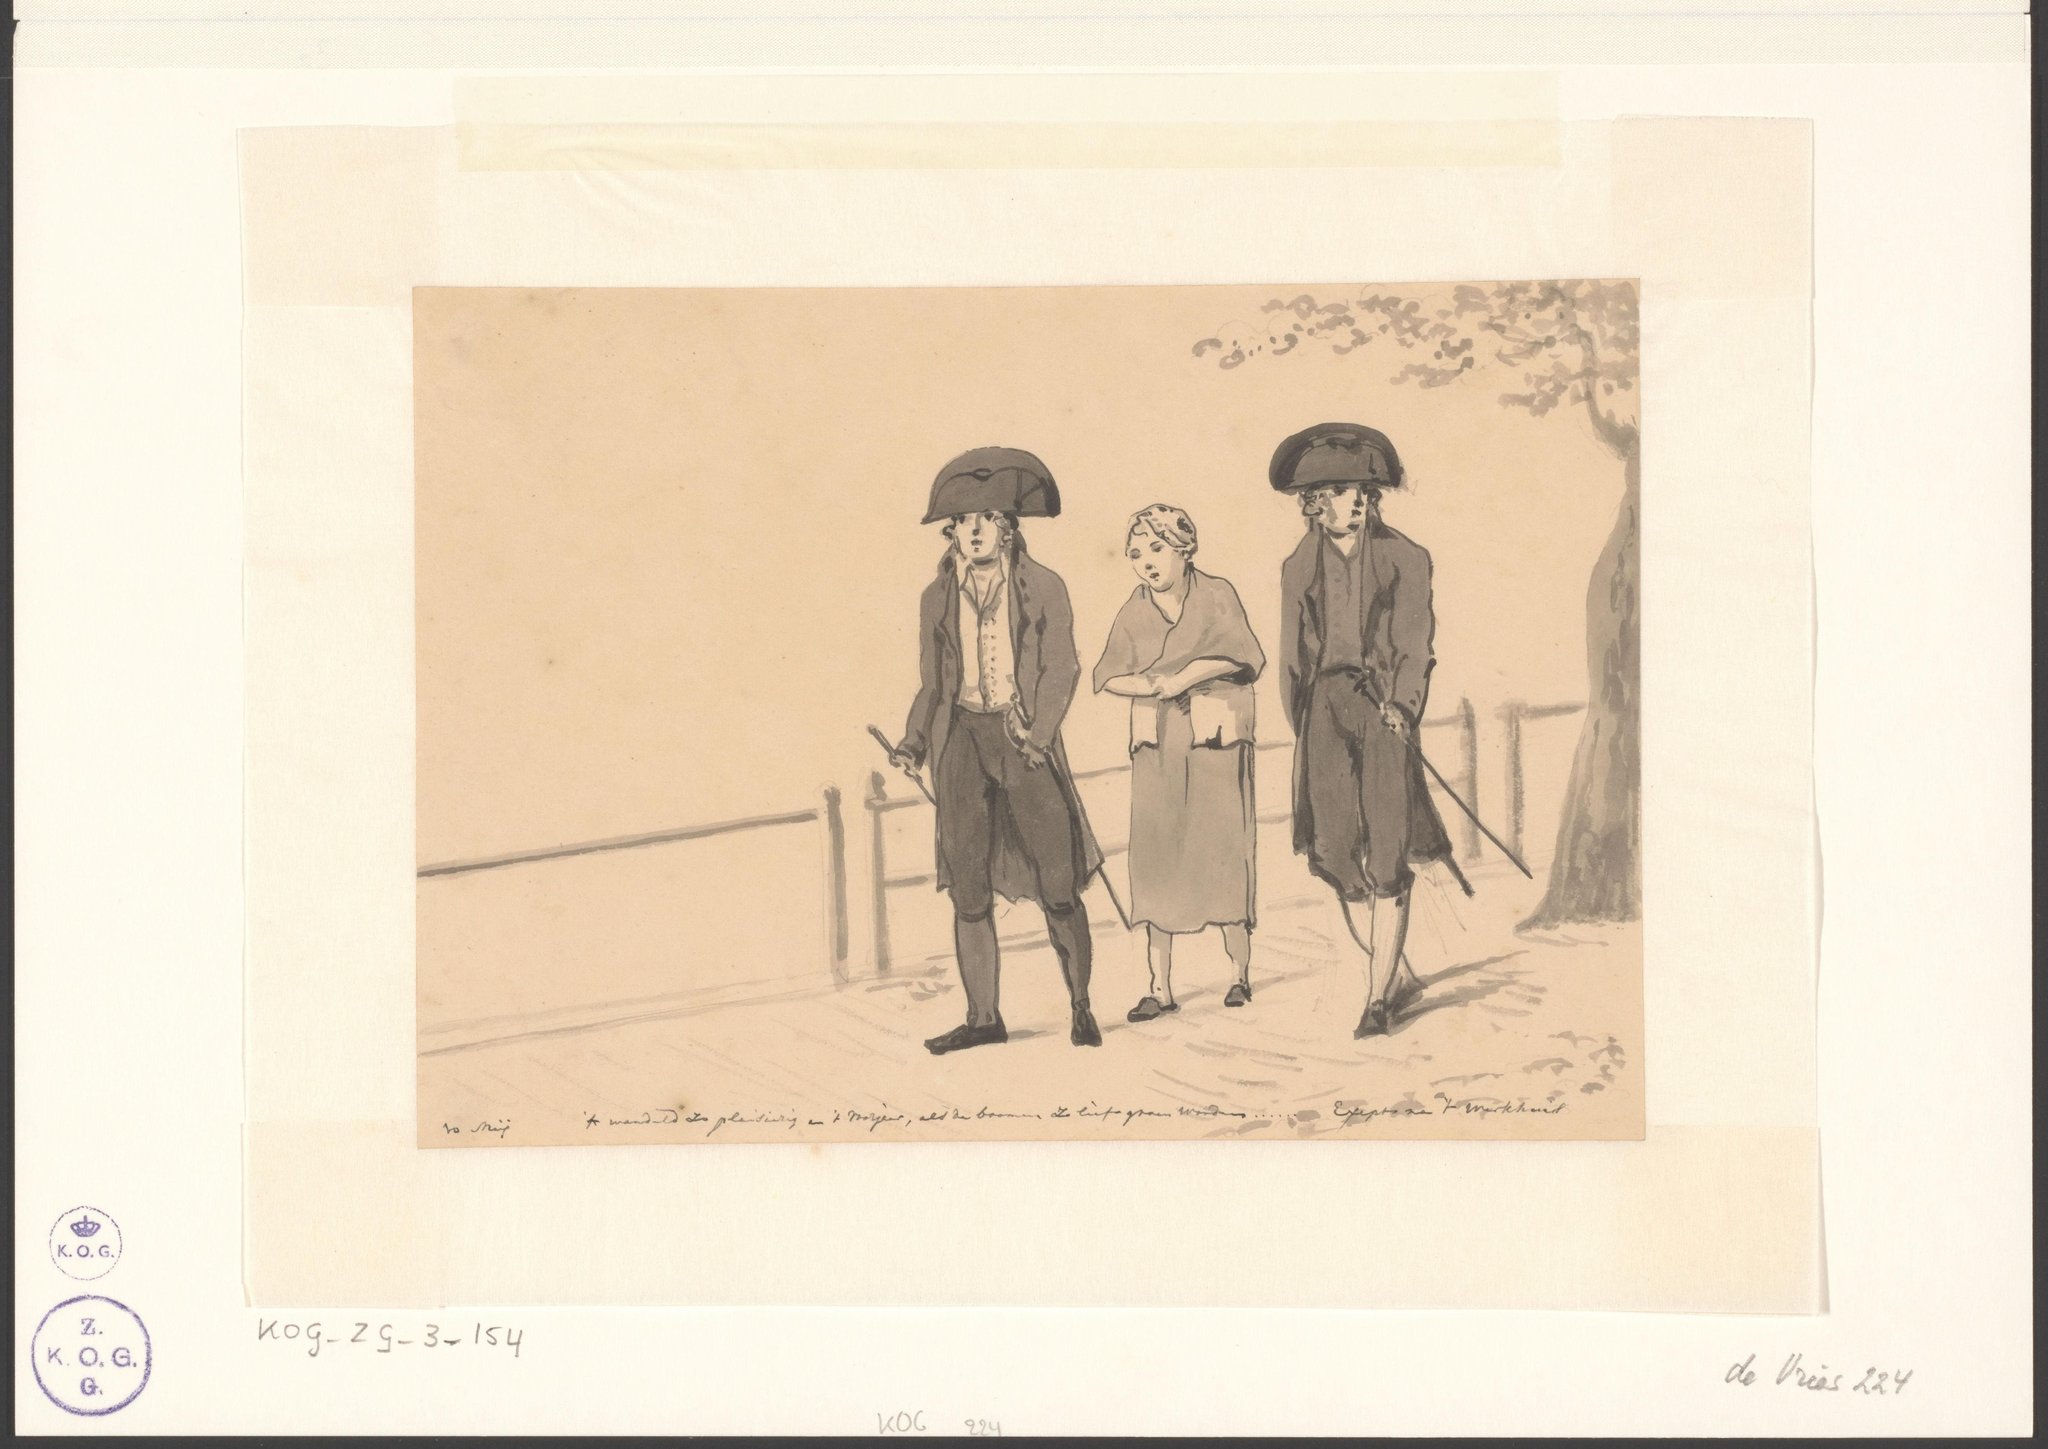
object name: drawing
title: Vrouw wordt door twee bewakers naar het Werkhuis gebracht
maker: christiaan andriessen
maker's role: draughtsman, print maker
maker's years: 1775-1846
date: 1806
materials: ink, paper, pencil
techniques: brush, pen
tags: prisoner; in fetters, workhouse, penal camp, penitentiary, chain gang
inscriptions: inscription: ‘10 maij 't wandeld zo plaisierig in 't voorjaar, als de boomen zo lief gaan worden .... Exept na 't werkhuis’, signature: ‘J Andriessen’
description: Dagboekblad uit het getekende dagboek dat Christiaan Andriessen bijhield van 1805 tot en met 1808.